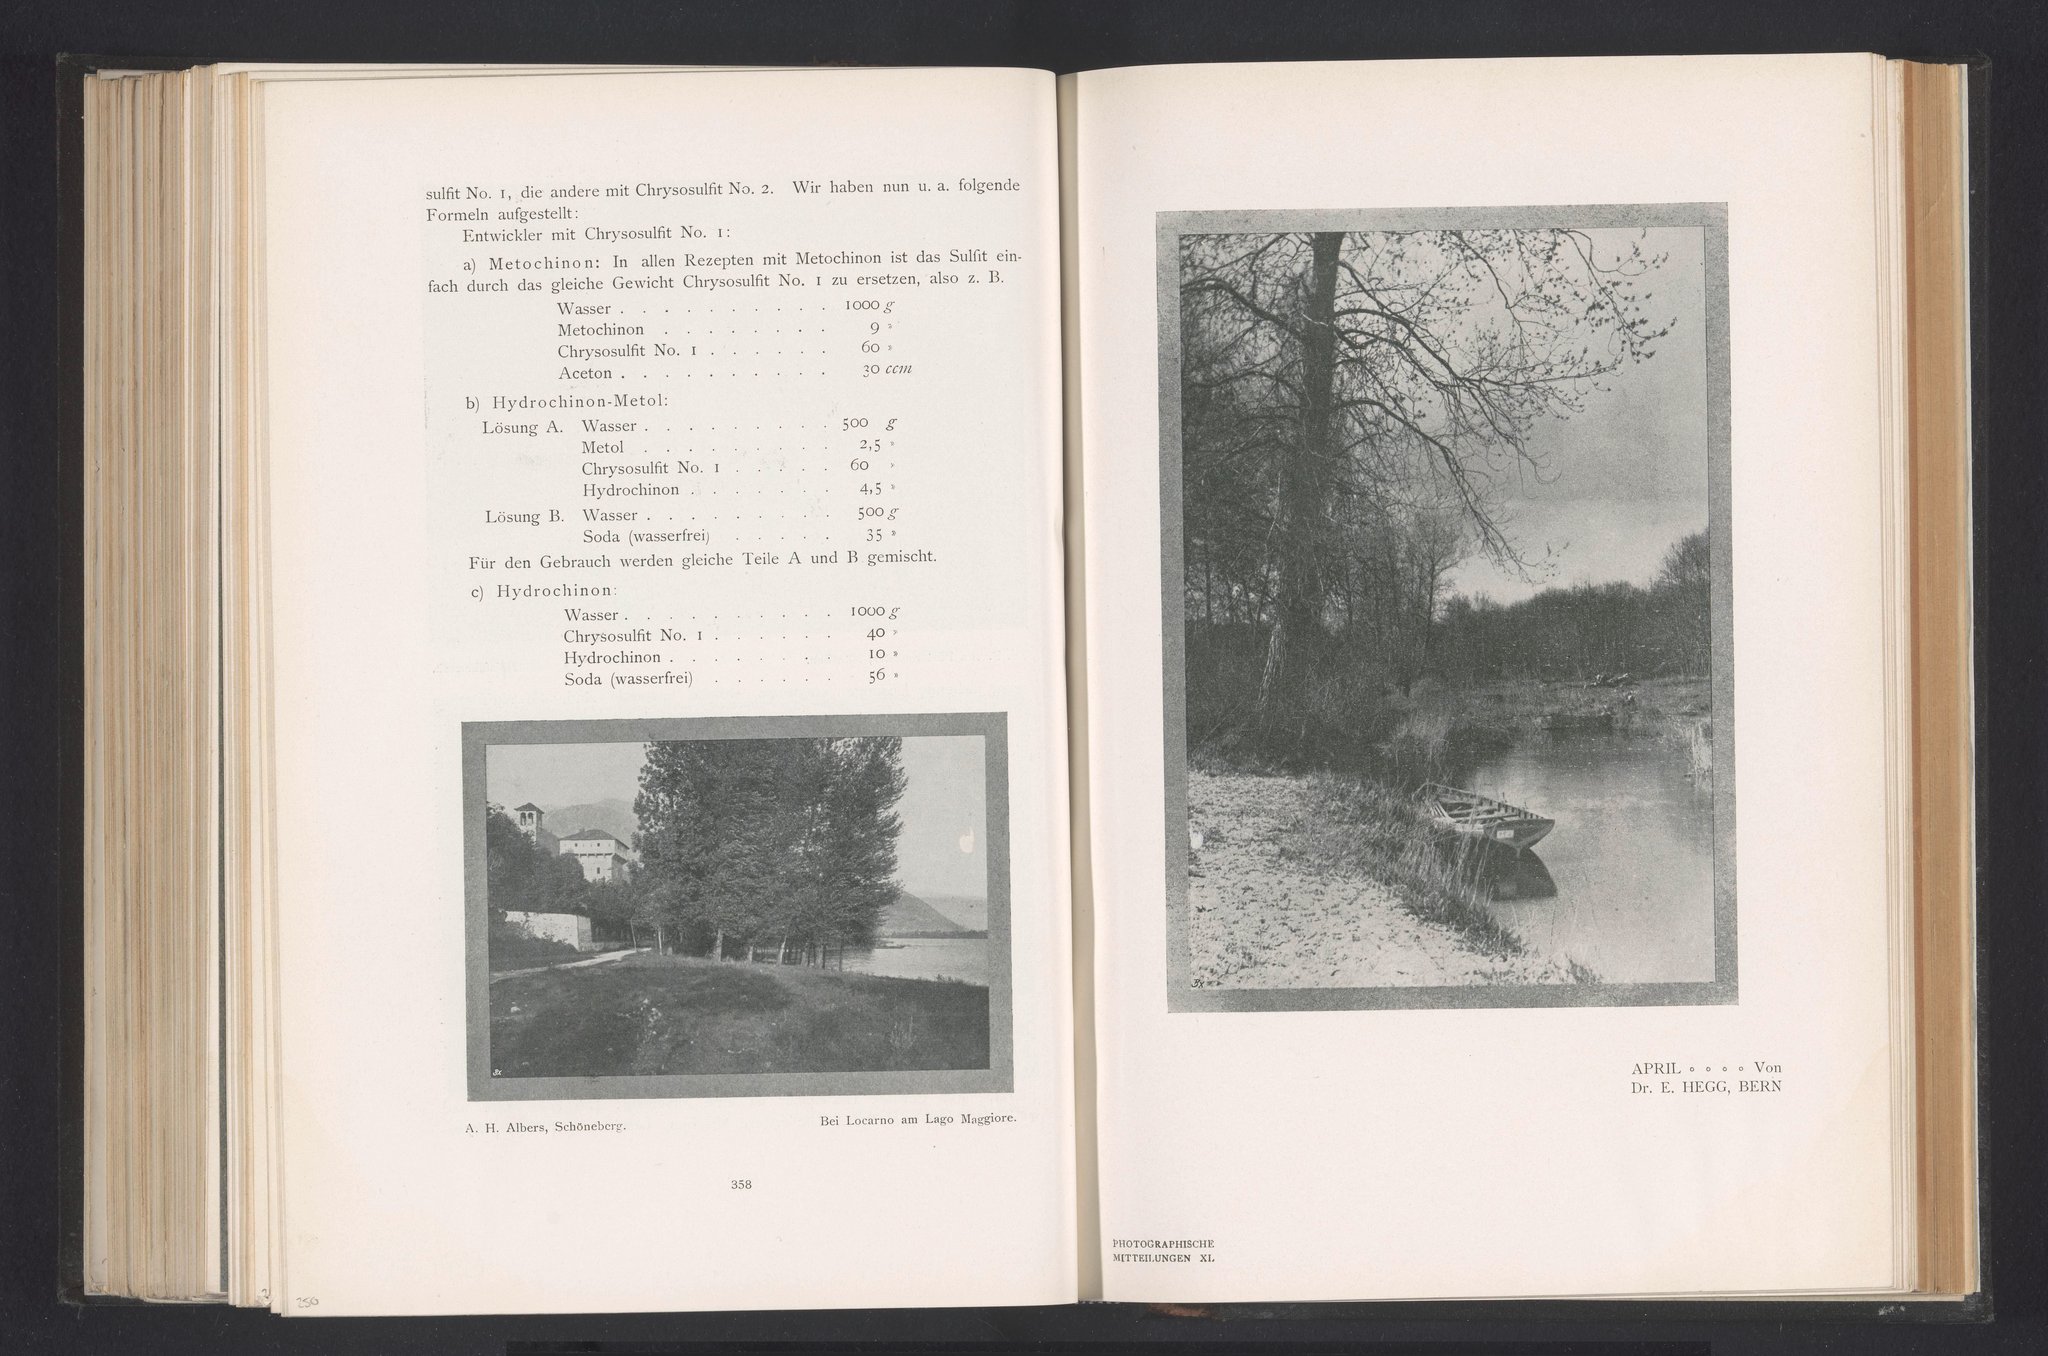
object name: photomechanical print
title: Bosgezicht met een vijver en roeiboot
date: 1898-1903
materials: paper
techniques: autotype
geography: bern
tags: rowing-boat, canoe, etc., pond, pool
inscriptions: inscription: ‘Photographische Mitteilungen XL’, monogram: ‘BX’